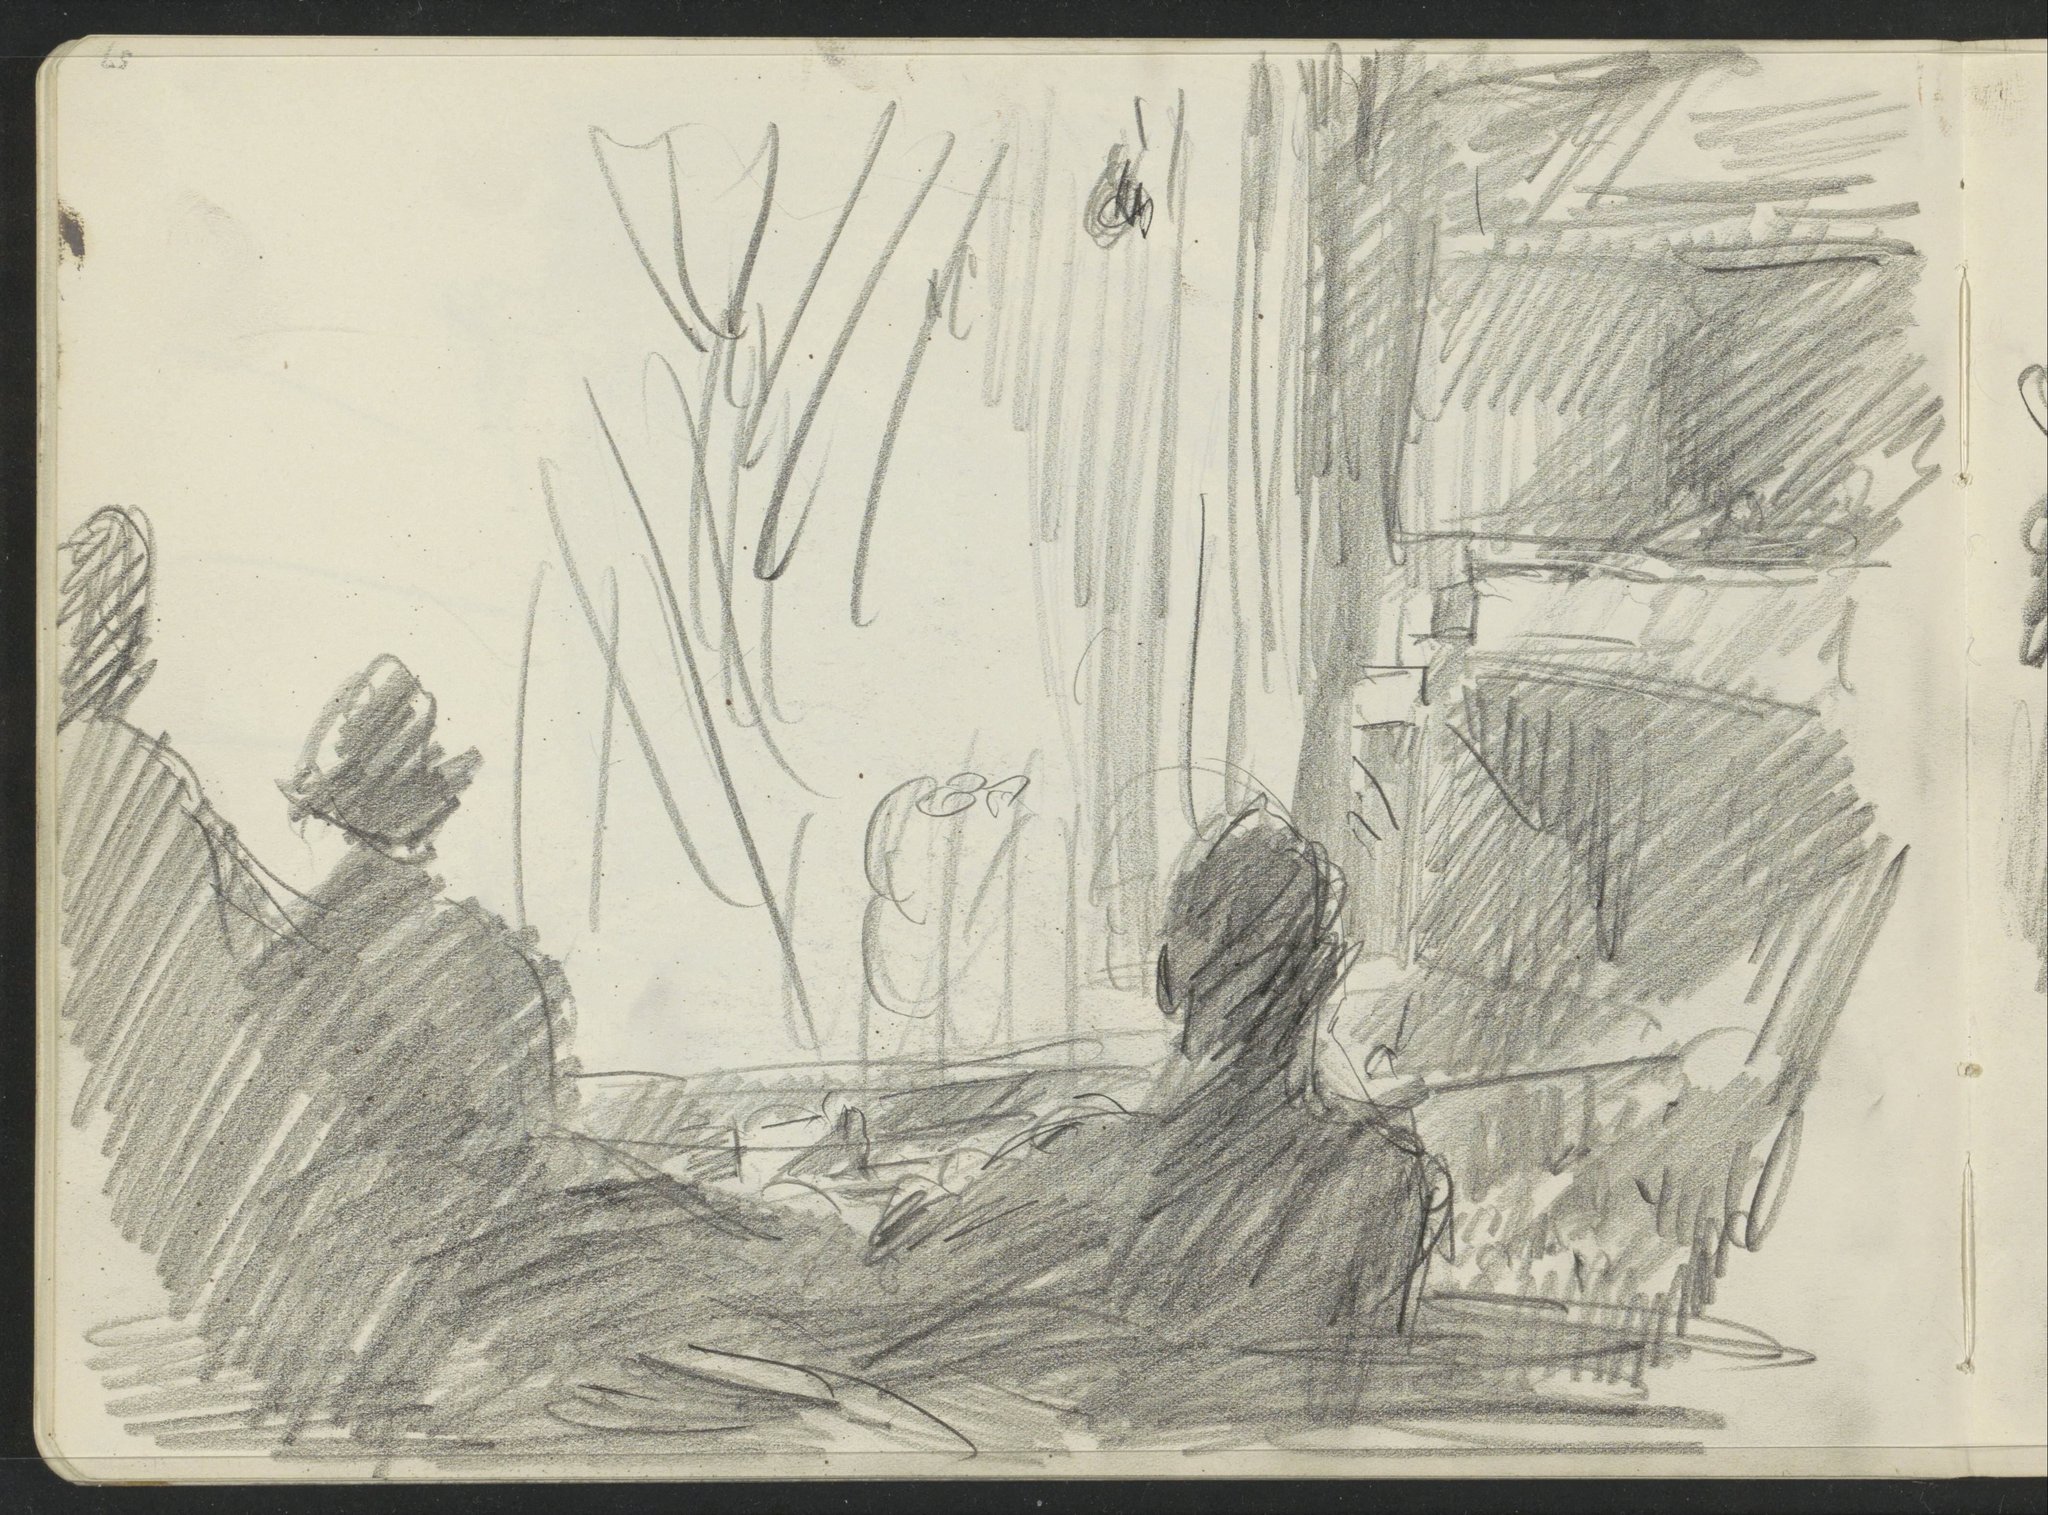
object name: sketchbook leaf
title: Toeschouwers op een theaterbalkon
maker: isaac israels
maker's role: draughtsman, painter, print maker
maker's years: 1865-1934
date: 1915-1934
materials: paper, pencil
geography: the hague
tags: boxes, loges ~ theatre, etc., the audience ~ art performance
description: Op de rug gezien. Op de achtergrond het toneel. Blad 14 verso uit schetsboek XVIII met 35 bladen.